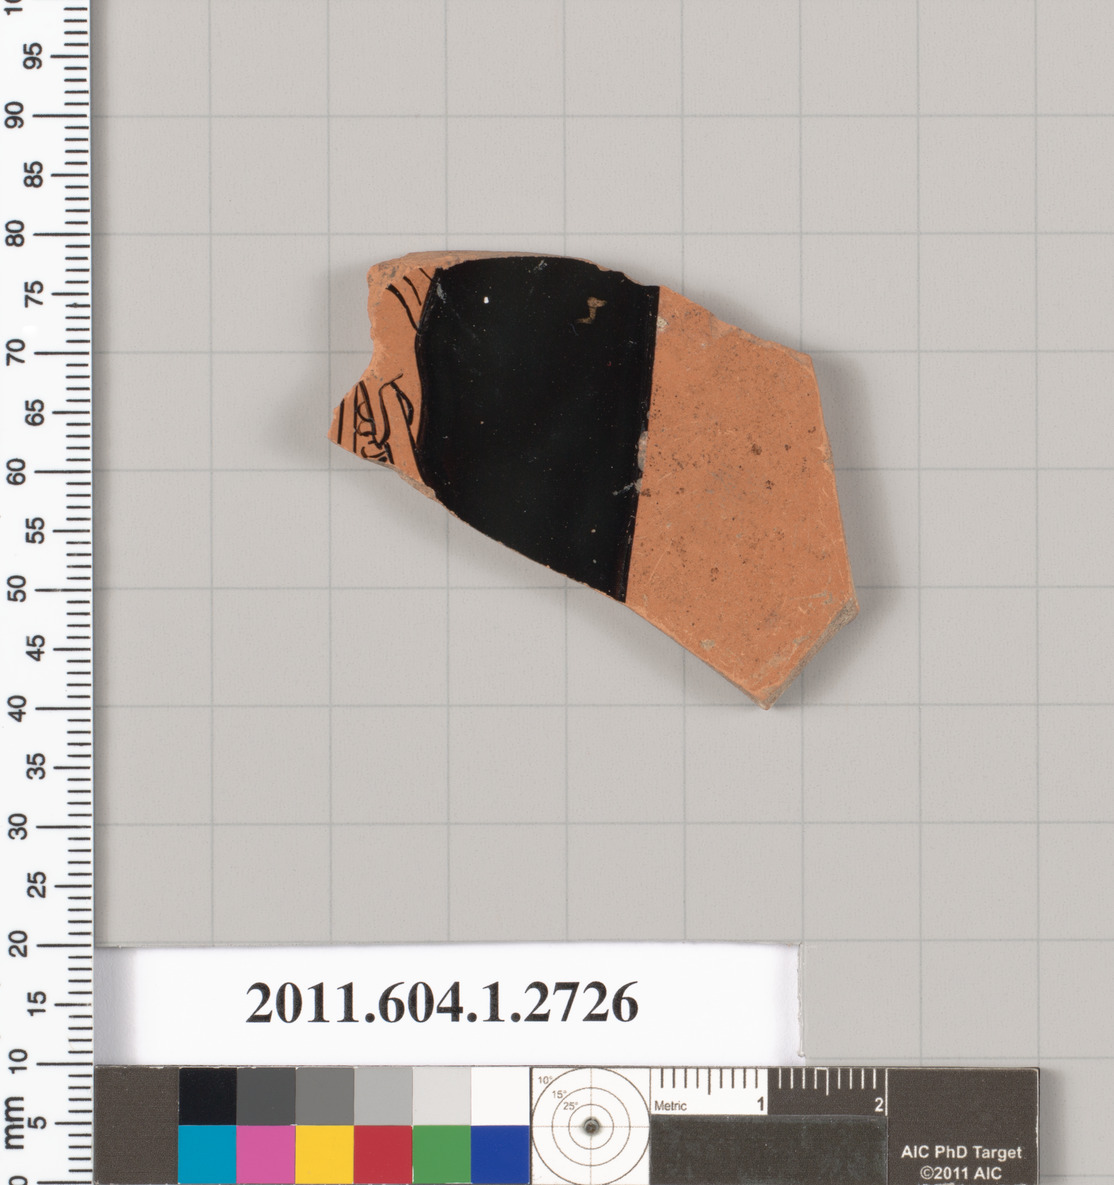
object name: kylix fragment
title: Terracotta fragment of a kylix (drinking cup)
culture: greek, attic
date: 490-480 BCE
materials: terracotta